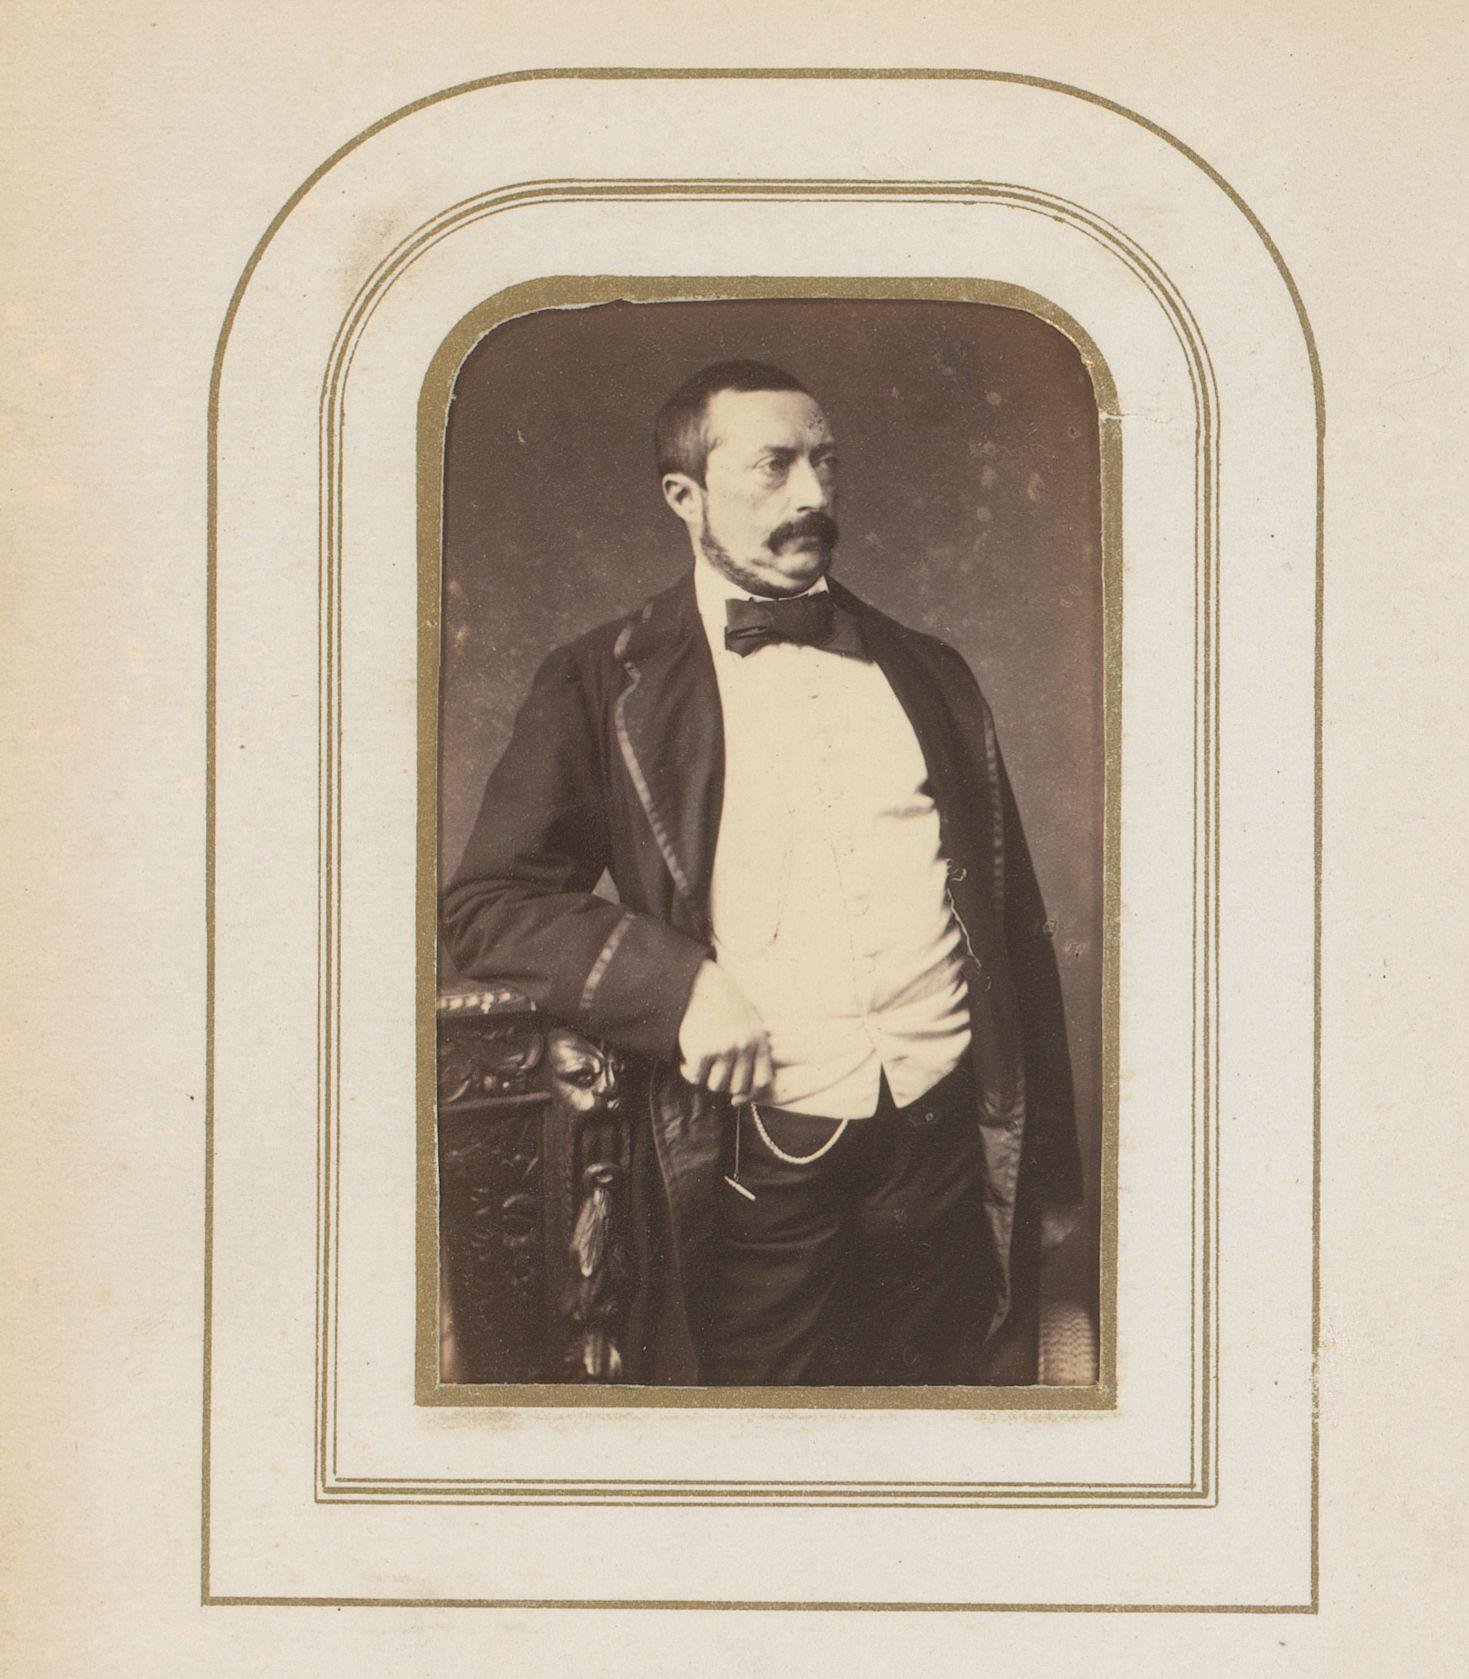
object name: carte de visite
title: Portret van een man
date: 1860-1894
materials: cardboard, photographic support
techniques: albumen print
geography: brussels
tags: standing figure, historical persons, beard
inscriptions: inscription: ‘Atelier de Photographie/ Ghémar Frères/ Photographes du Roi/ 27, rue de l'Ecuyer/ entrée par la porte cochère/ Bruxelles’